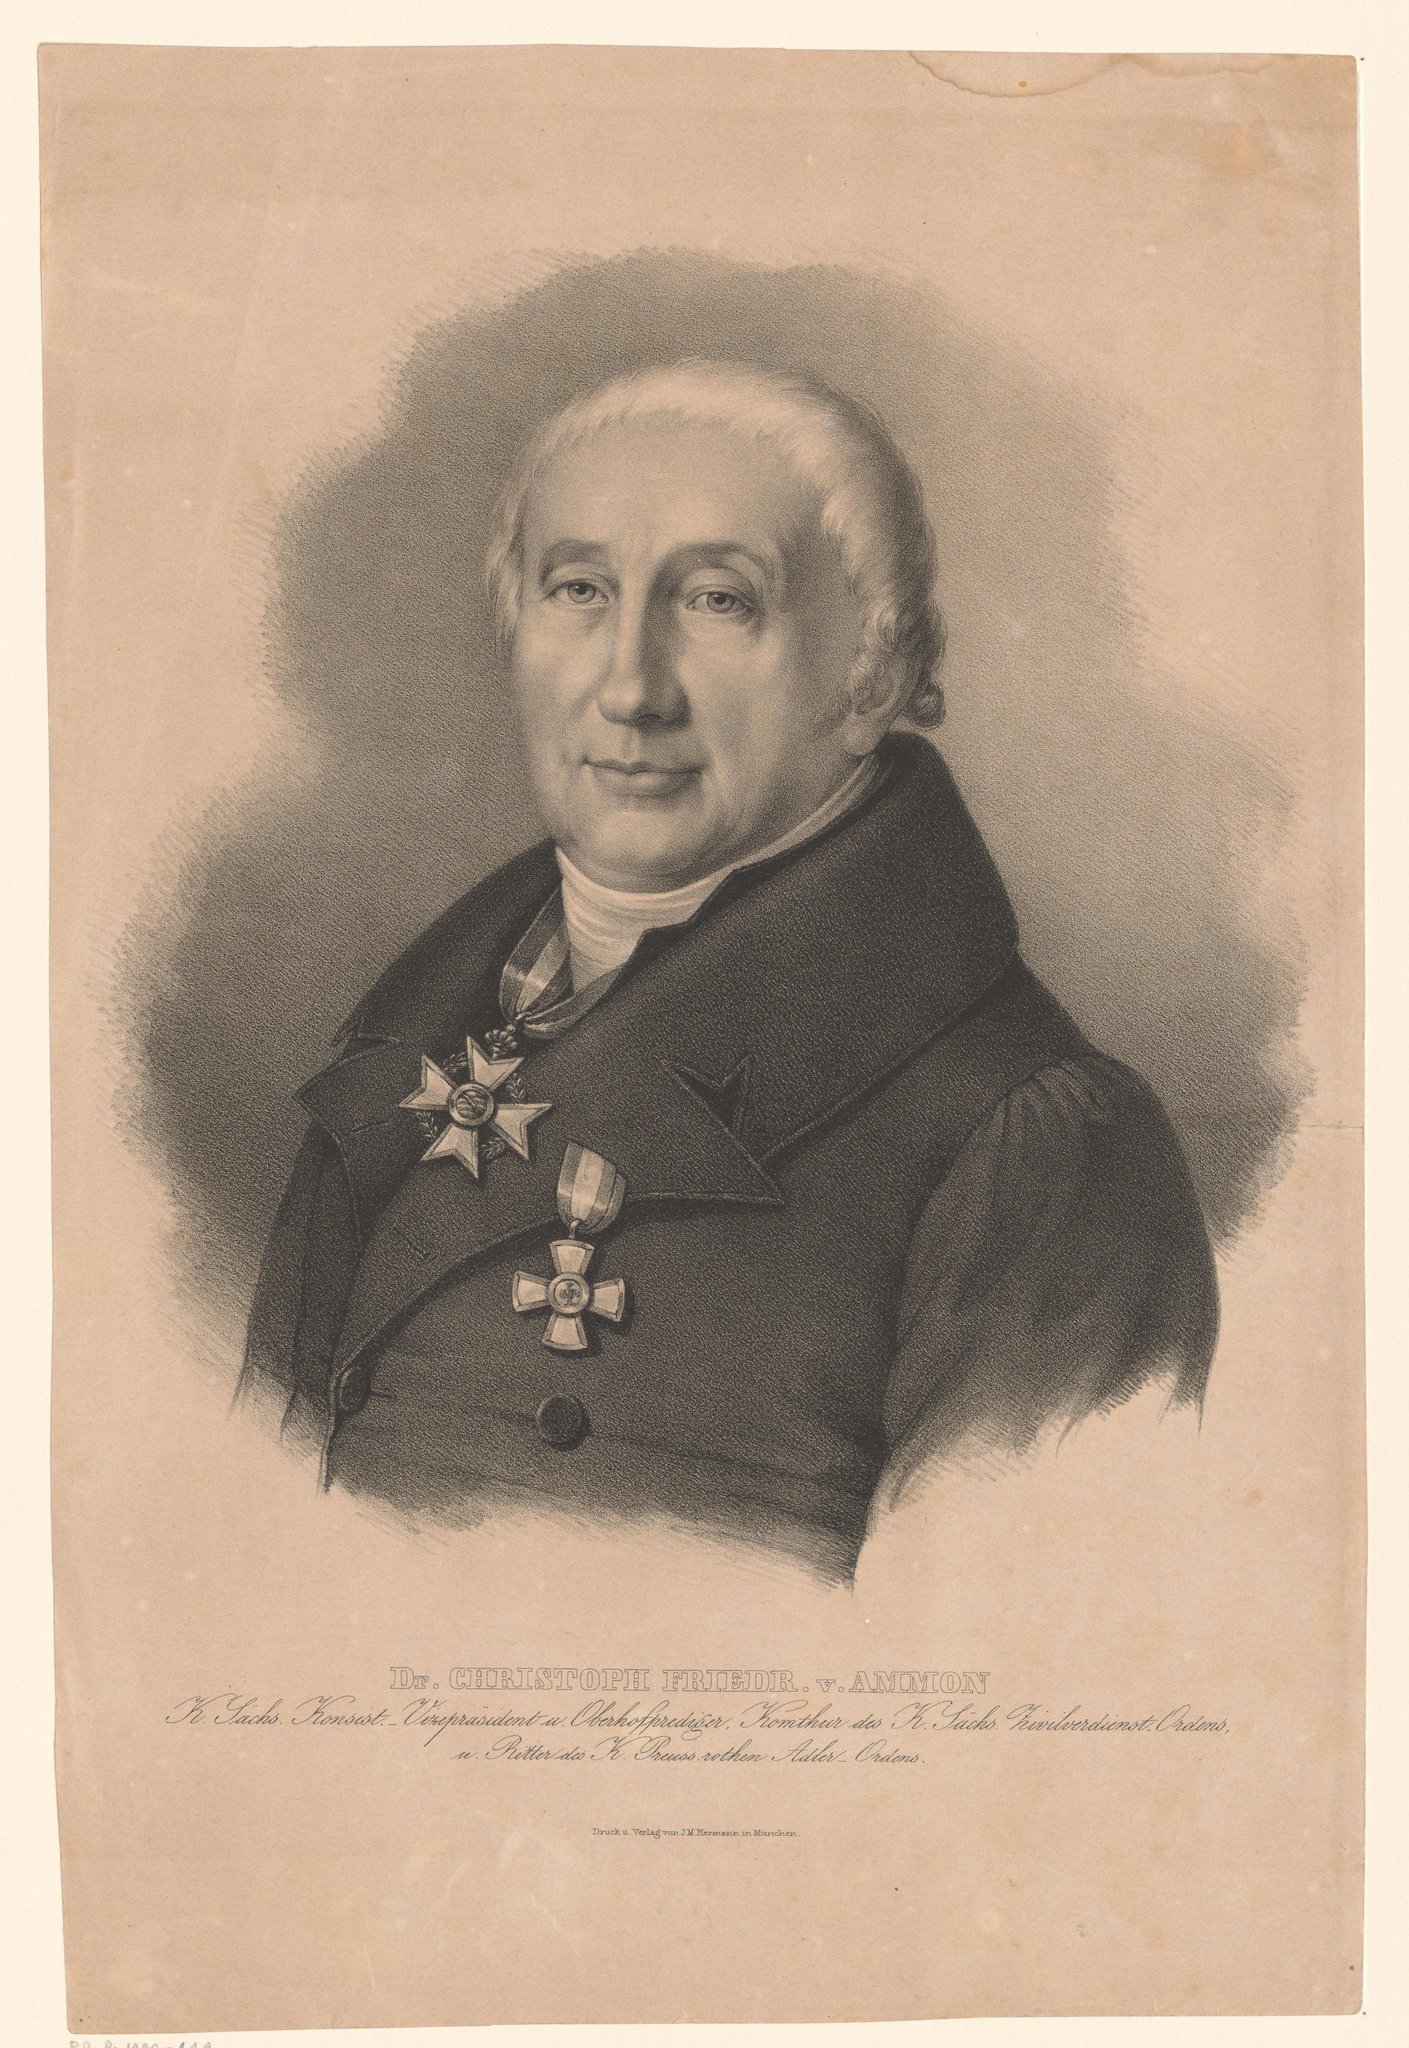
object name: print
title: Portret van Christoph Friedrich von Ammon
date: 1830-1860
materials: paper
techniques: lithograph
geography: munich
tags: theologian, historical persons, functionaries and dignitaries ~ episcopal protestant churches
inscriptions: collector's mark: Lugt 2228, collector's mark: Lugt 2760, collector's mark: Lugt 4100